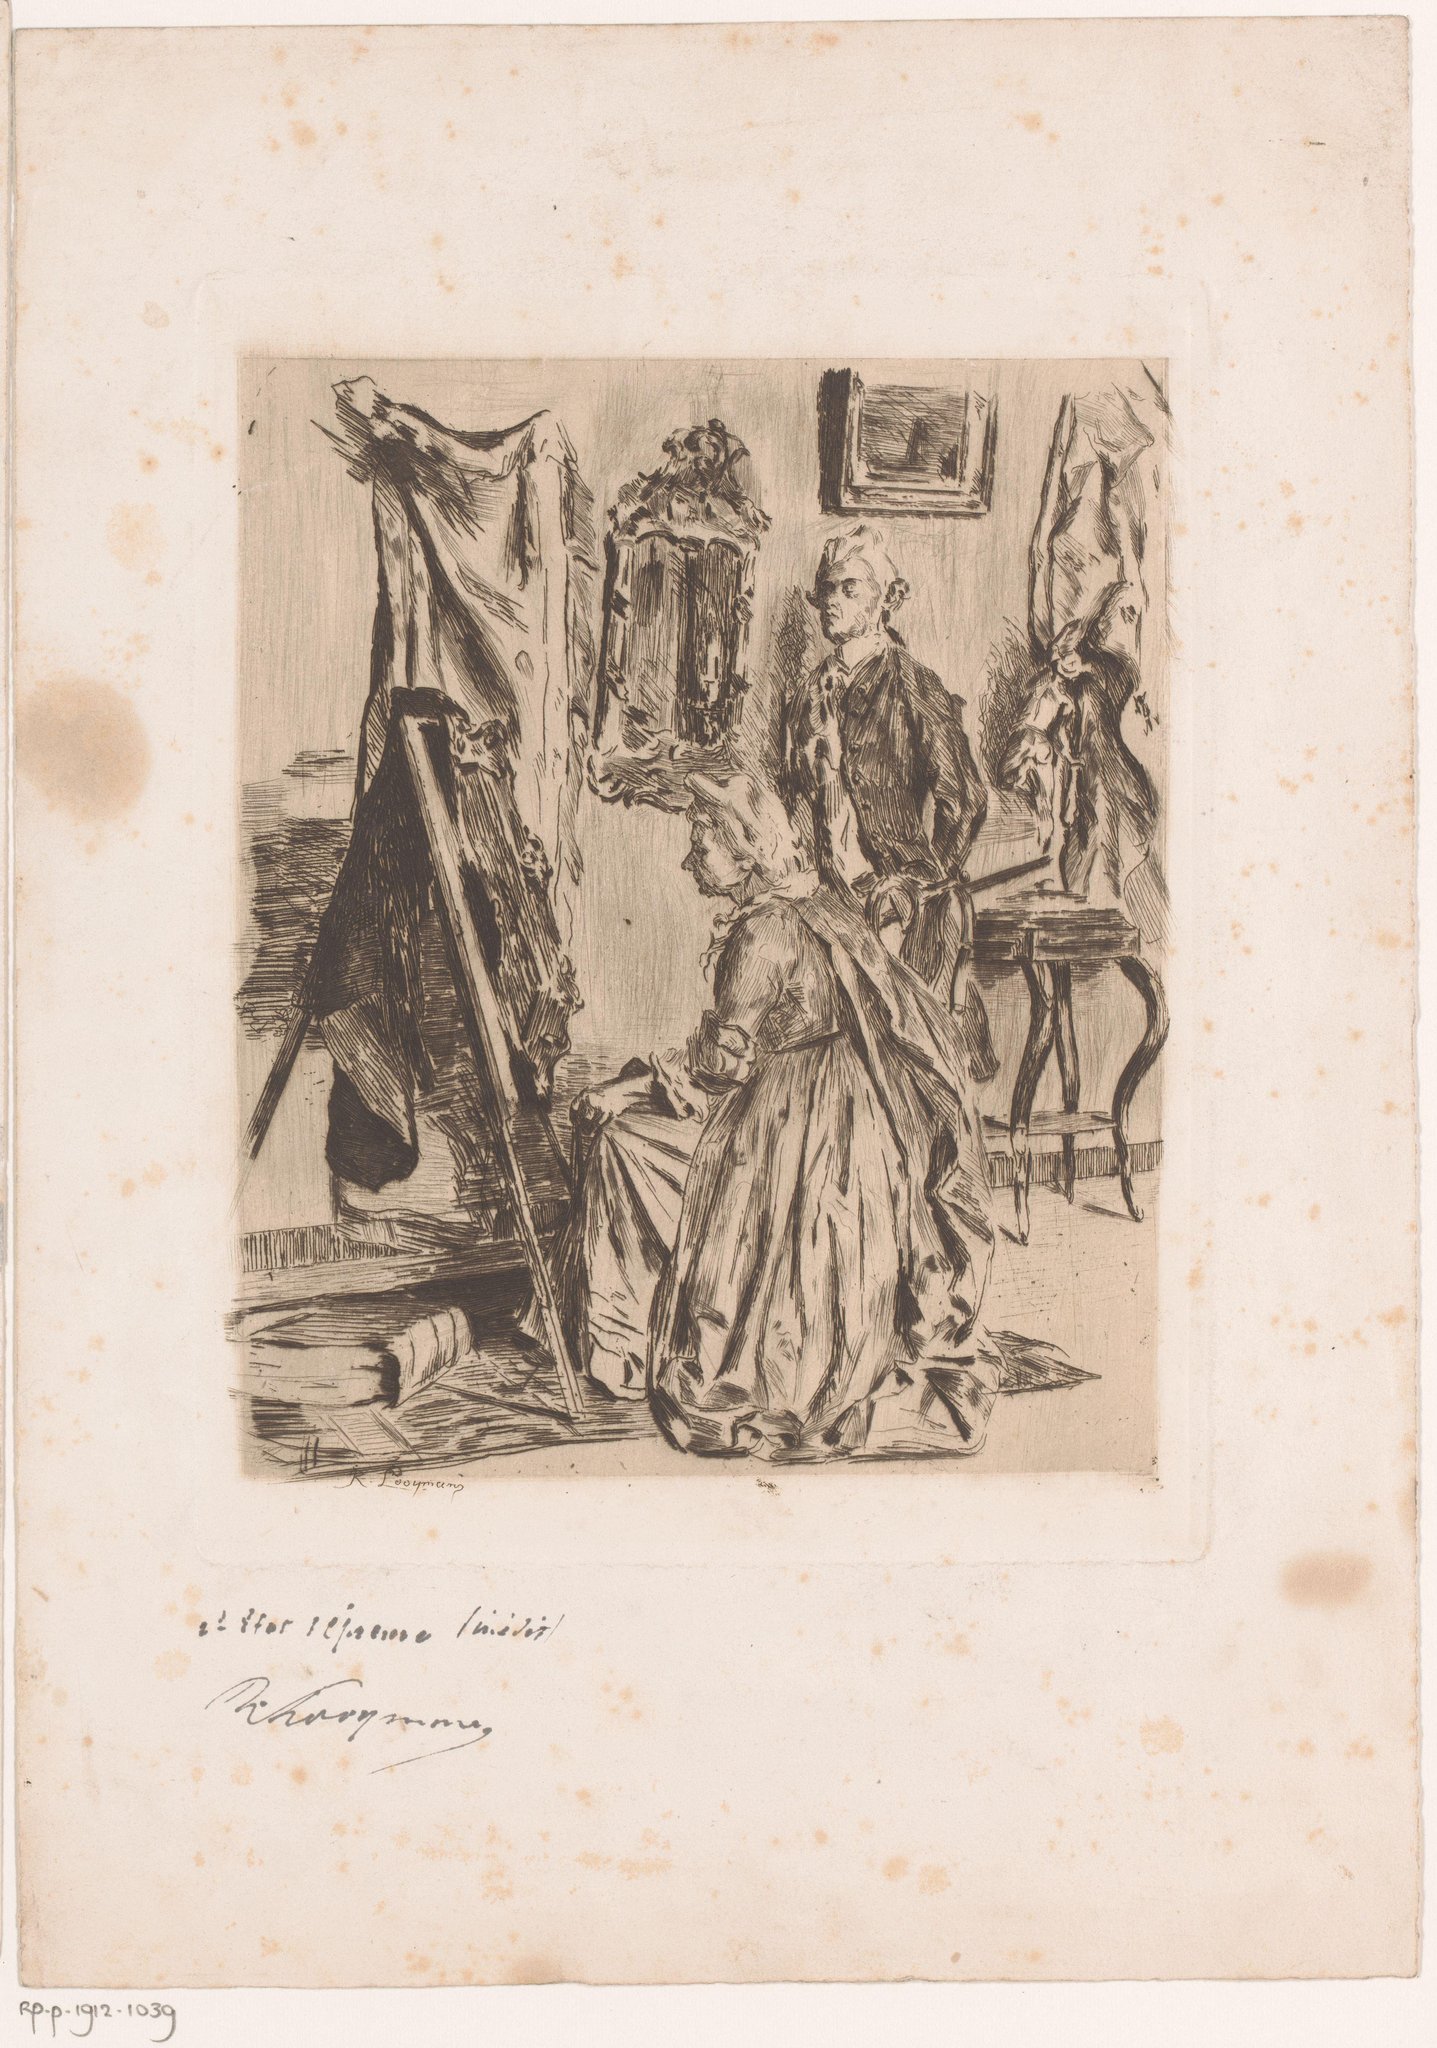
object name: print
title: Interieur met een man en vrouw bij een schildersezel met daarop een ingelijst werk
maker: romain looymans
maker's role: print maker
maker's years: 1864-1914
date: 1889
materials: paper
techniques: drypoint, etching, intaglio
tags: workshop, studio ~ painter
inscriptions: collector's mark: Lugt 2228, annotation: ‘2e Etat 1 épreuve (inédit)’